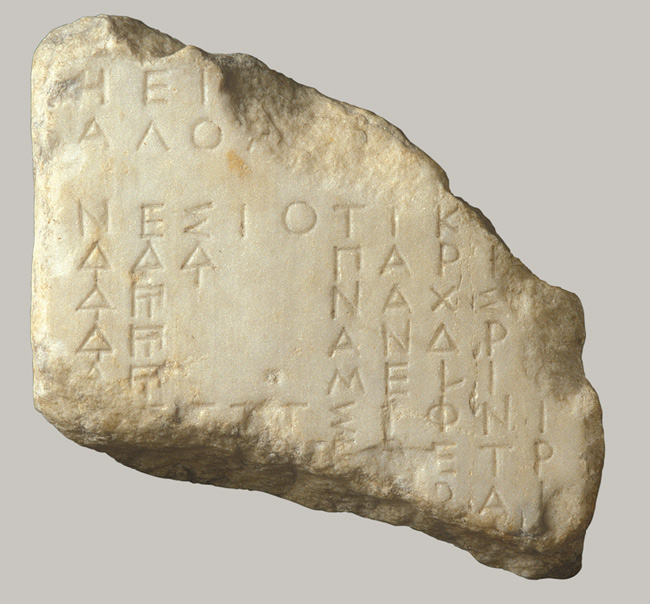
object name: inscription, athenian tribute list fragment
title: Fragmentary marble inscription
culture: greek, attic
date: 425-424 BCE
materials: marble